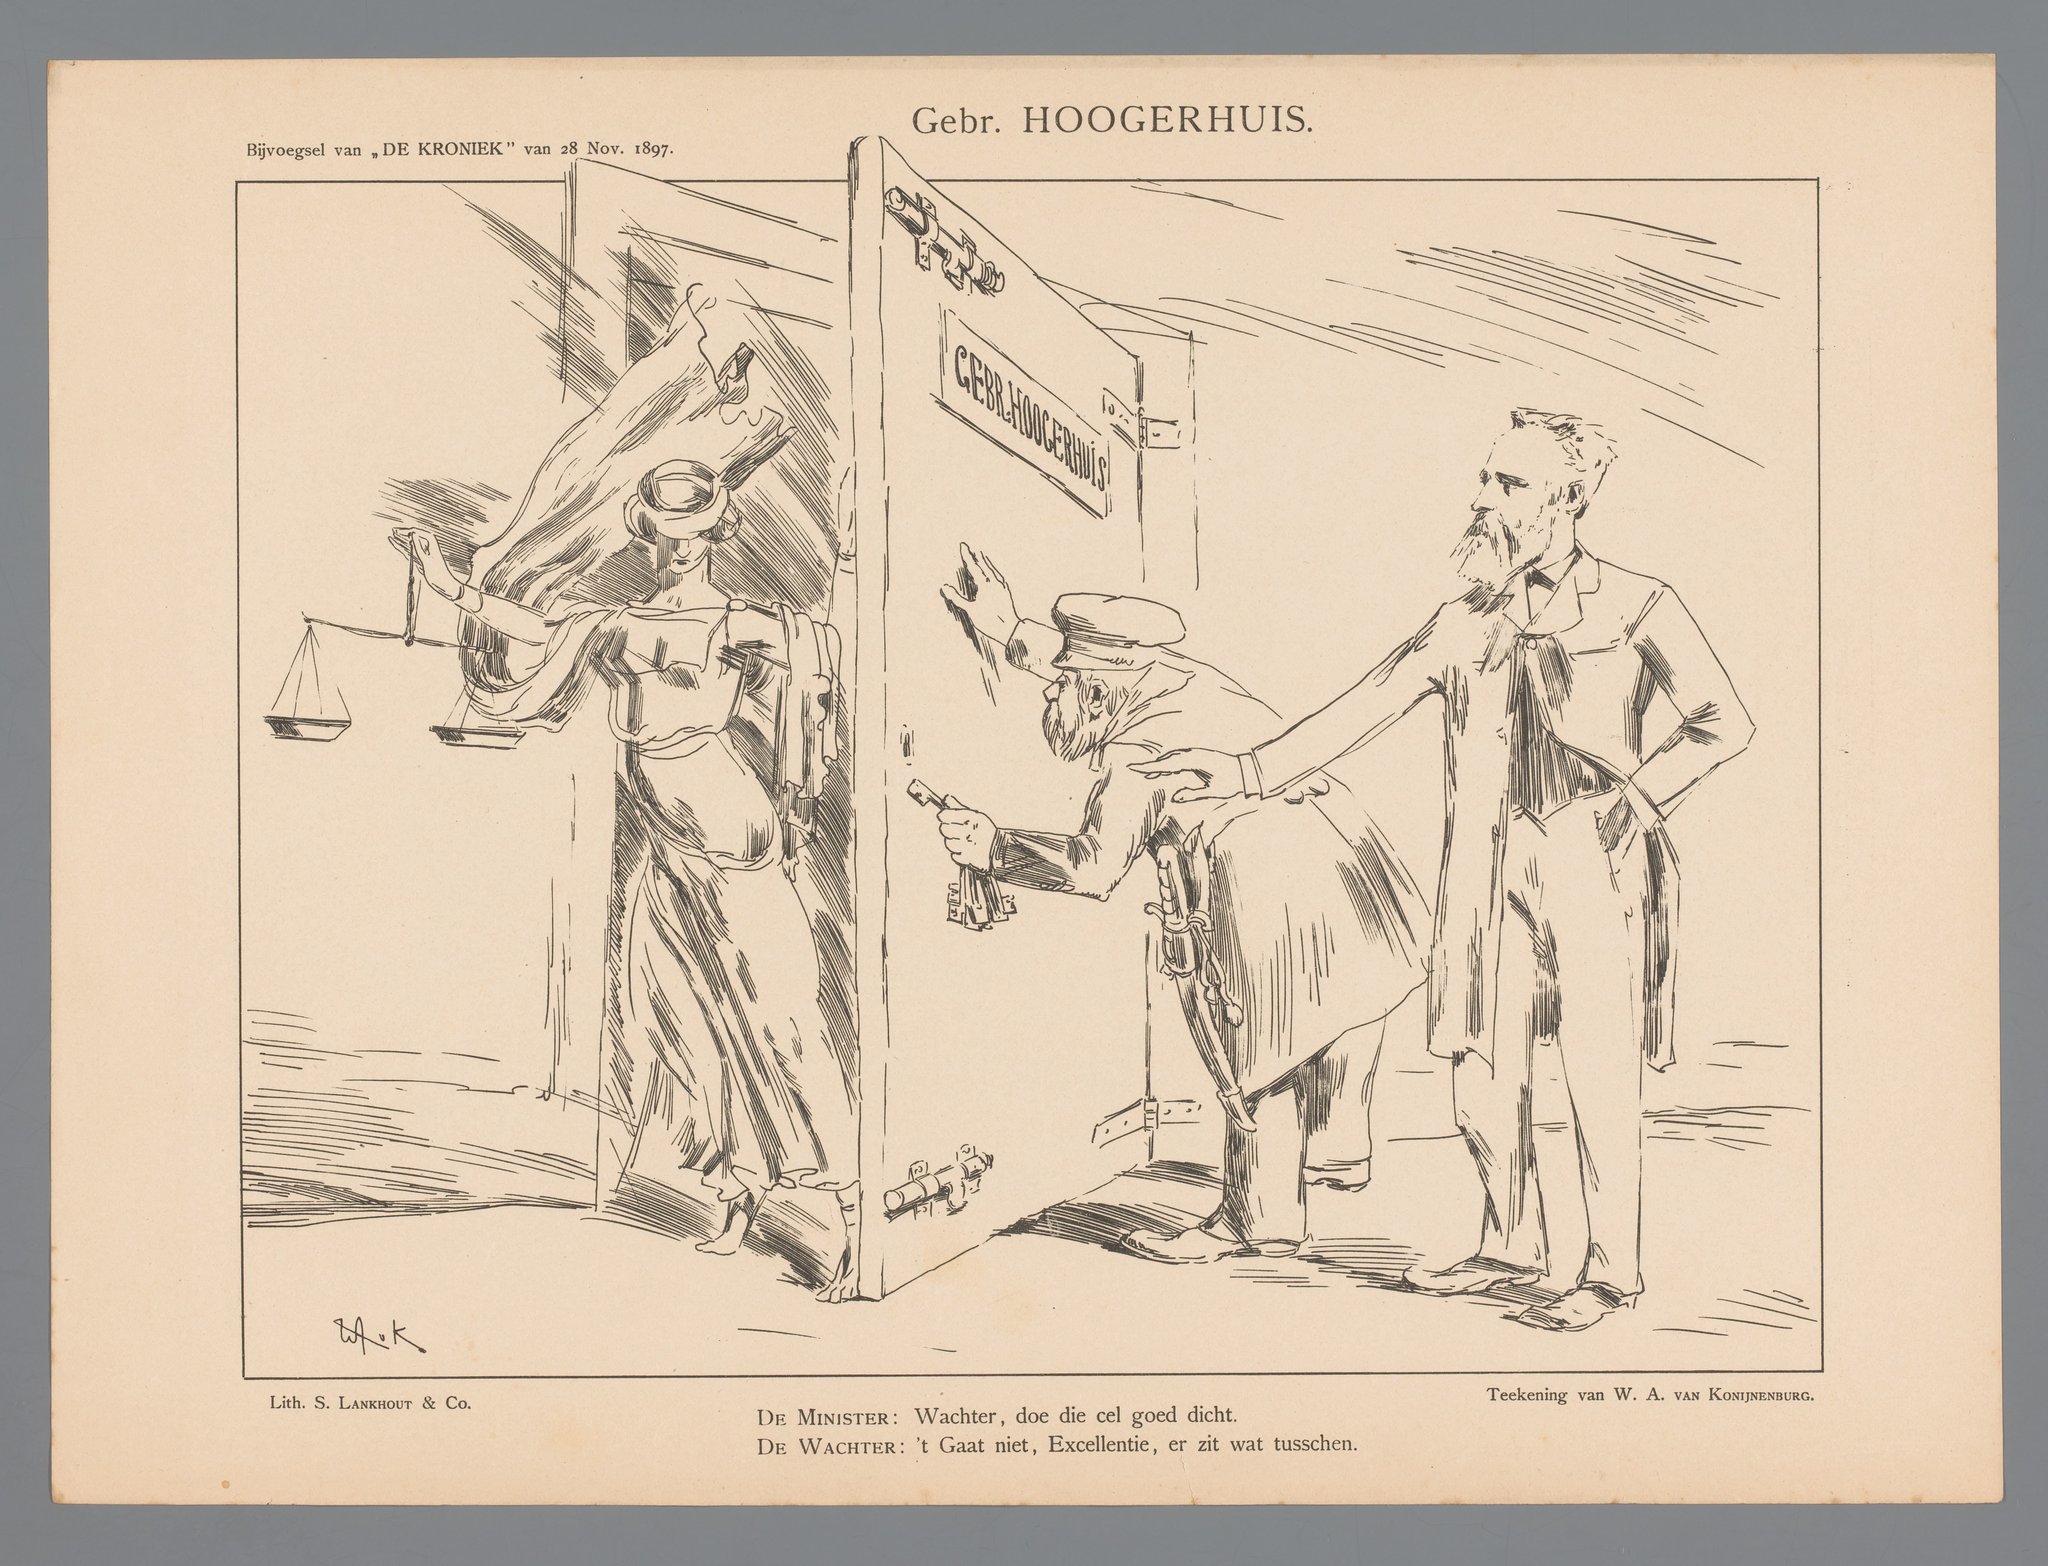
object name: print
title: Gebr. Hoogerhuis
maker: willem van konijnenburg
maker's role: draughtsman, painter, print maker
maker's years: 1868-1943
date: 1897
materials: paper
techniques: lithograph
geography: the hague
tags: prison, jail, justice, 'justitia'; 'giustitia divina' (ripa) ~ one of the four cardinal virtues, political caricatures and satires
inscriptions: date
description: Prent uit het bijvoegsel van: De Kroniek 3 (1897), 28 november 1897.